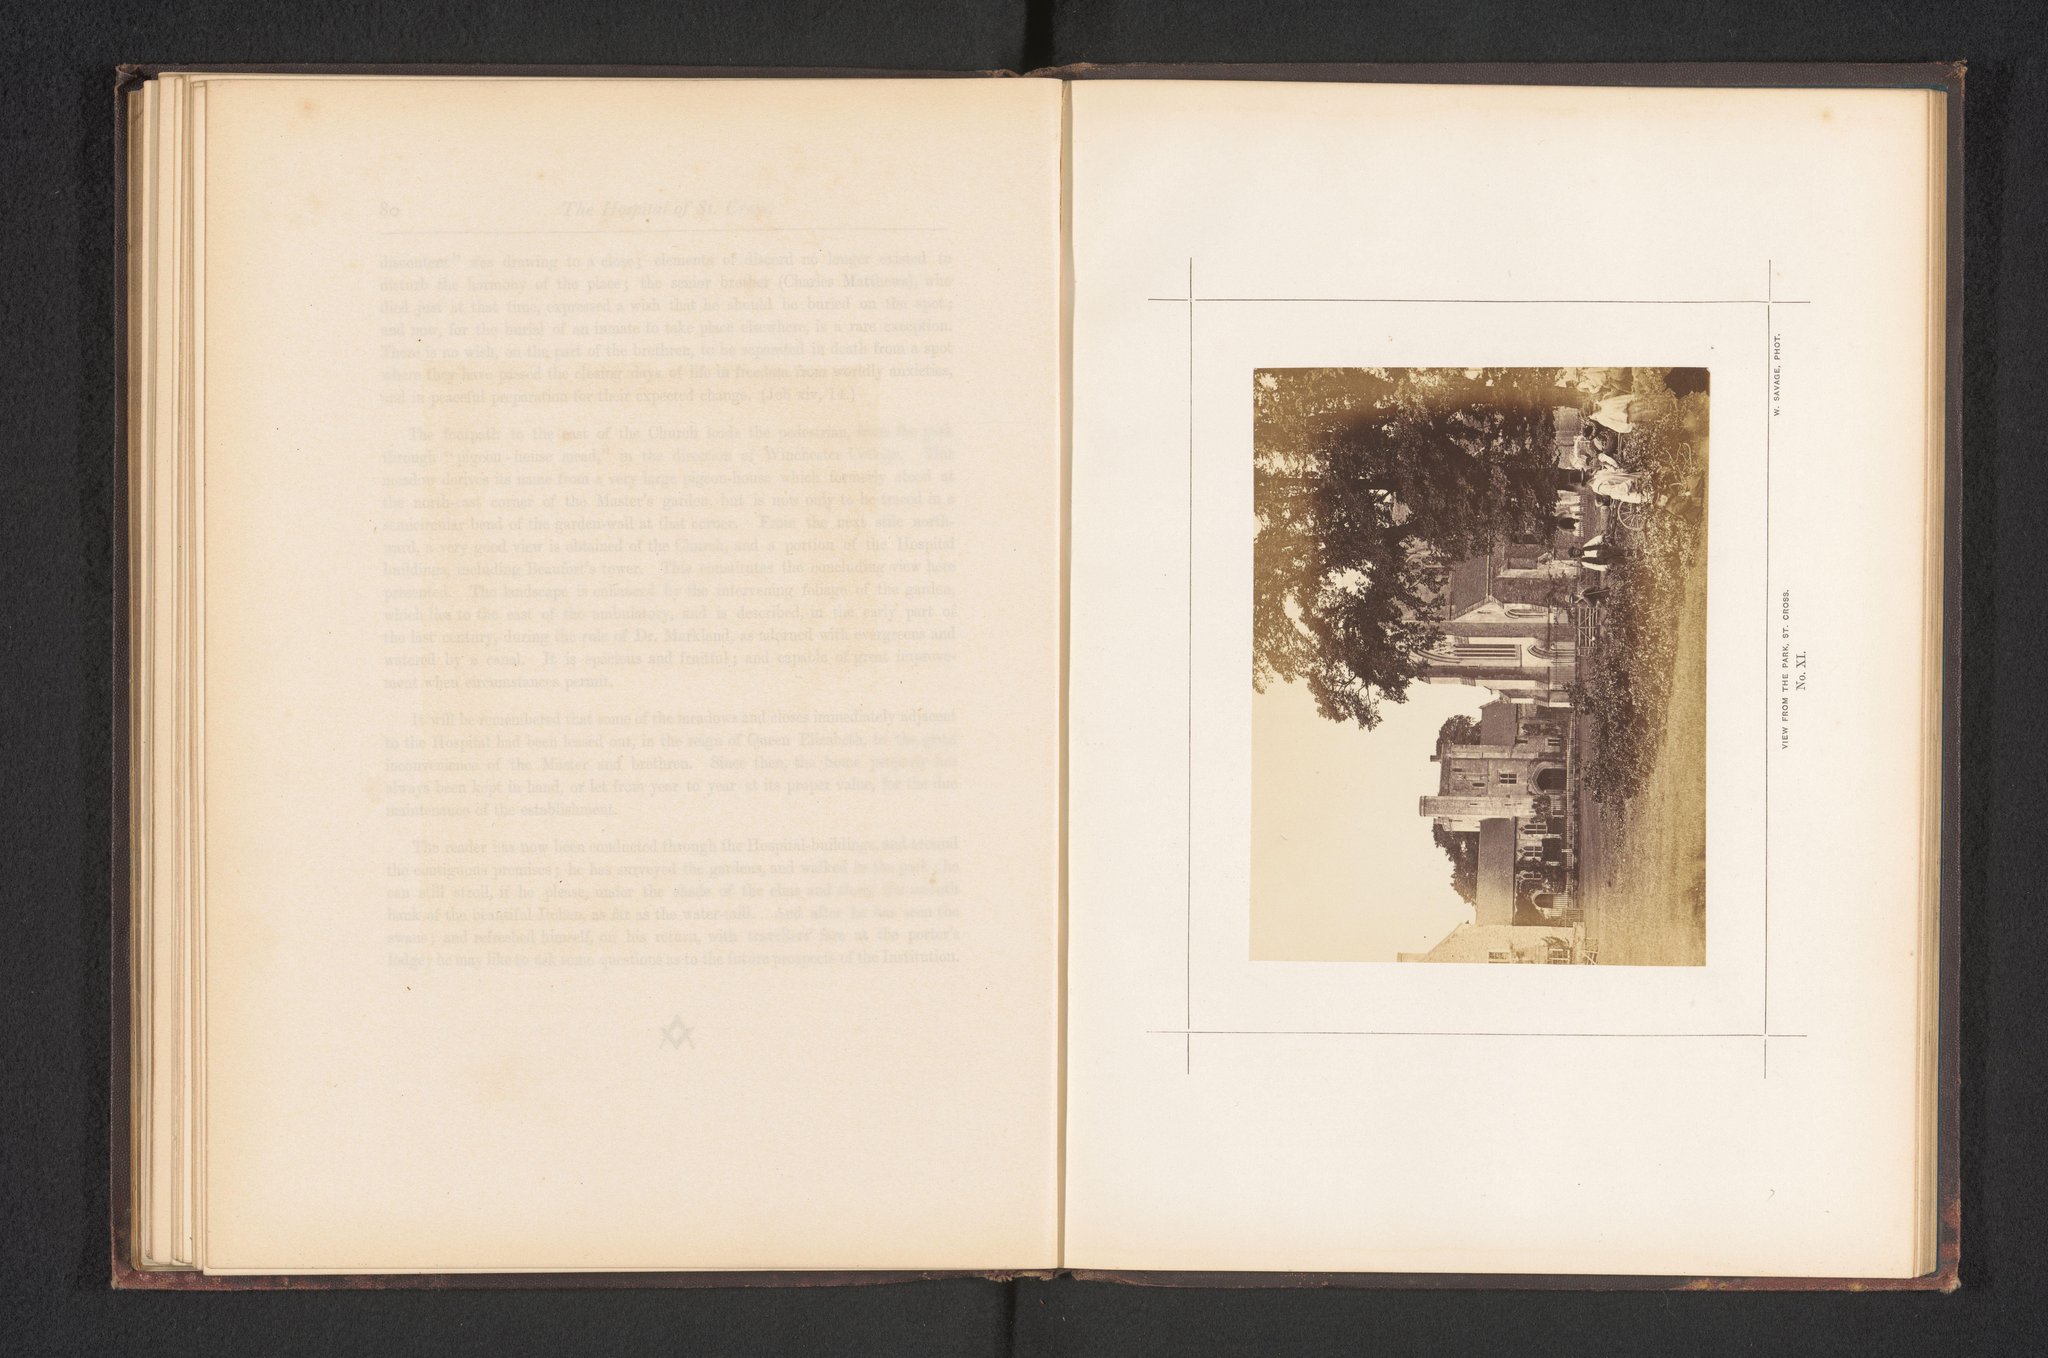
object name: photograph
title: View from the park, St. Cross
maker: william savage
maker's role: fotograaf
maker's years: 1817-1887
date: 1863-1868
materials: photographic support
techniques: albumen print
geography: winchester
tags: church (exterior), hospital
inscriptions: inscription: ‘No. XI.’